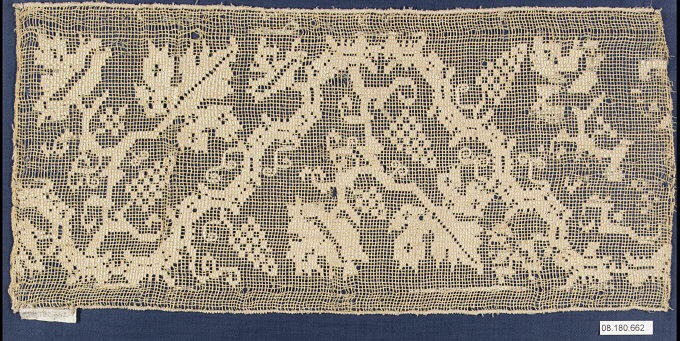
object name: band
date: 1501-1600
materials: silk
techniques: embroidery